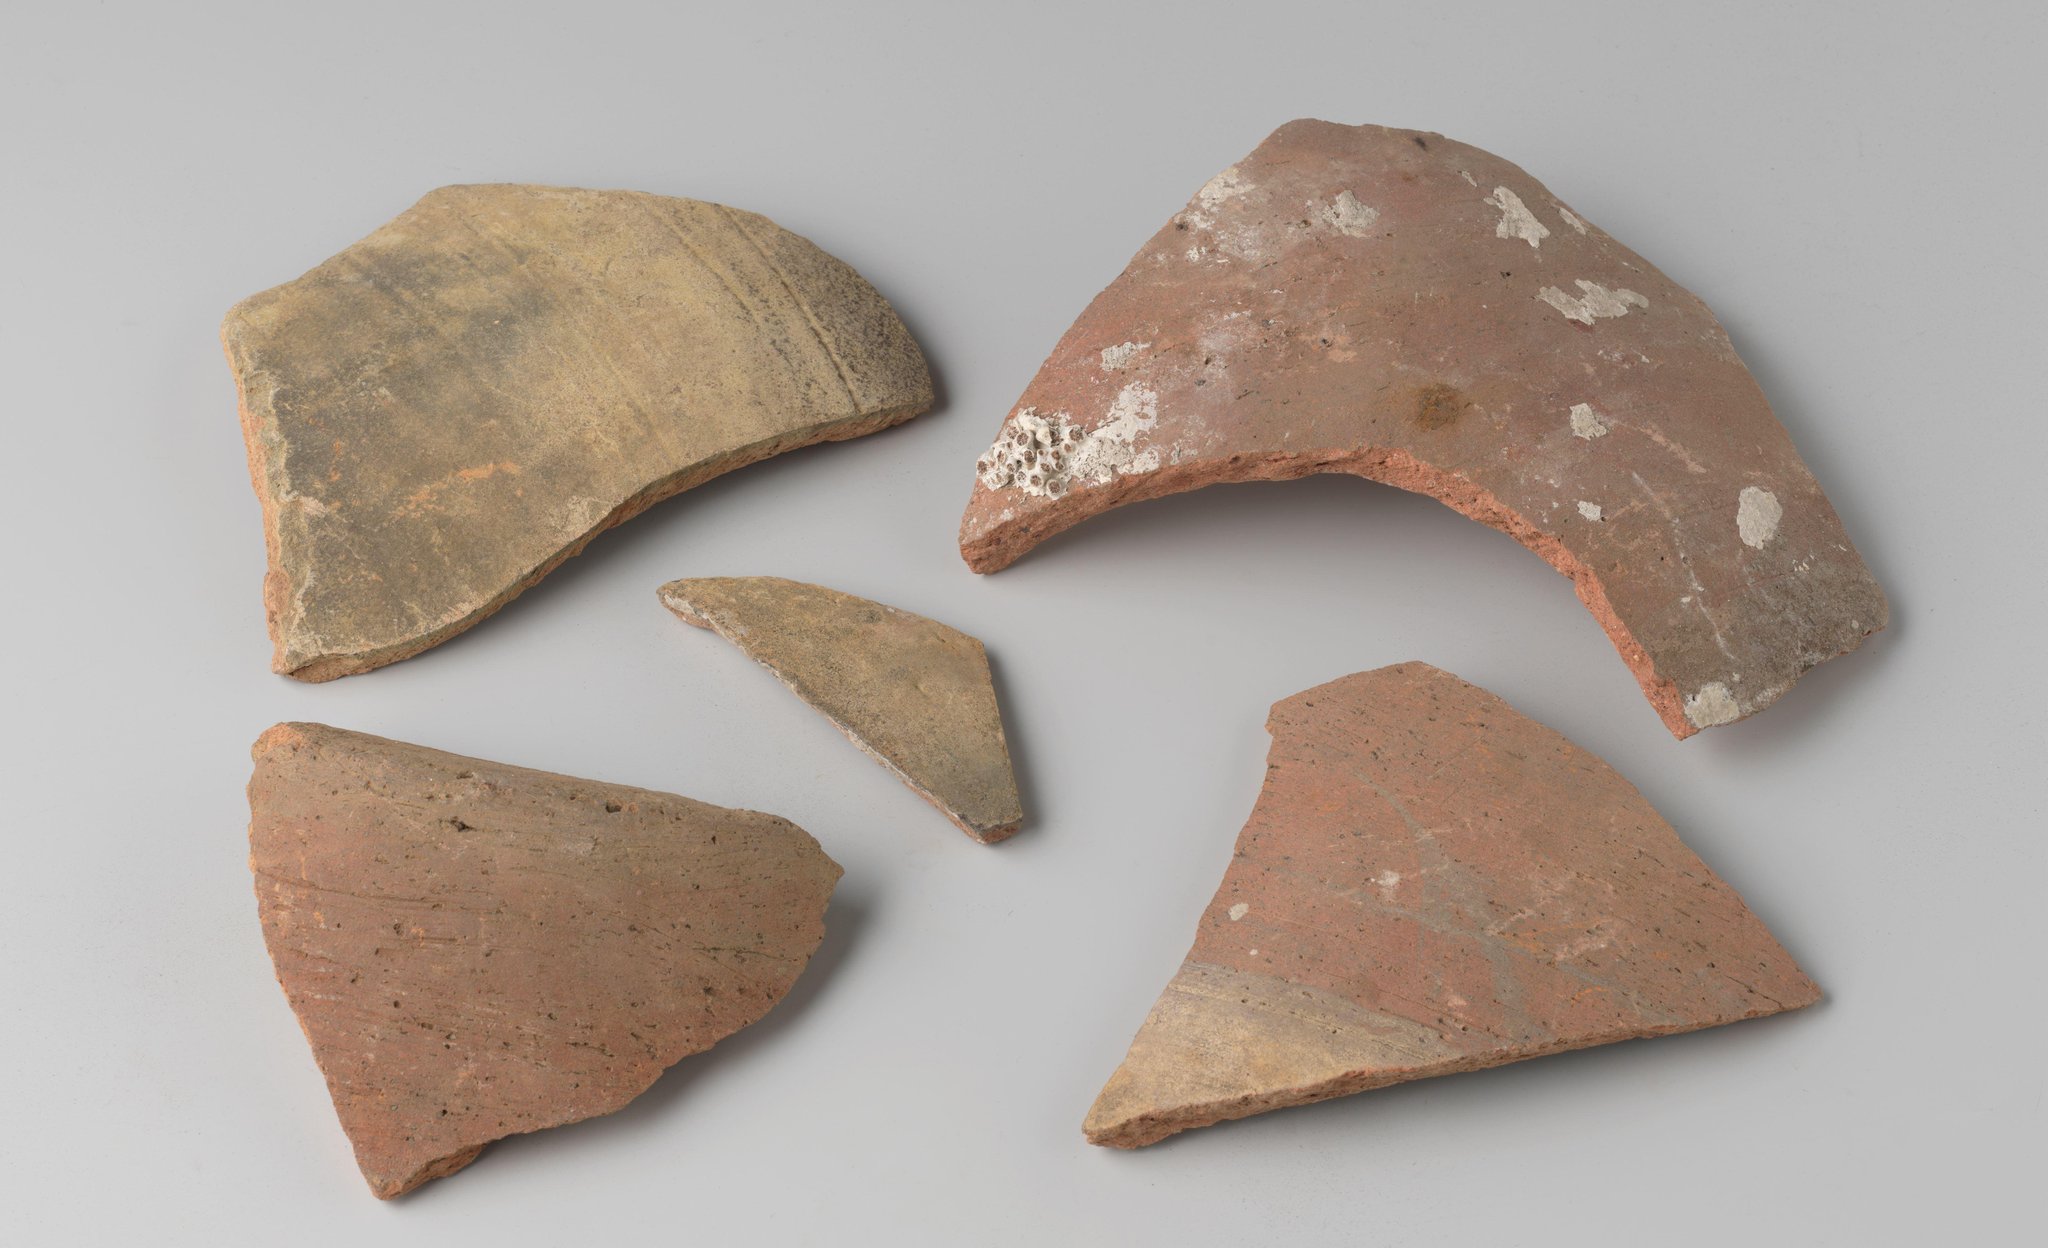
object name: sherd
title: Scherven aardewerk uit V.O.C.-schip de 'Witte Leeuw'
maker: Anonymous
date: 1613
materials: earthenware, stoneware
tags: verenigde oostindische compagnie, sint-helena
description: Scherven roodakkend aardewerk uit V.O.C.-schip de 'Witte Leeuw'.